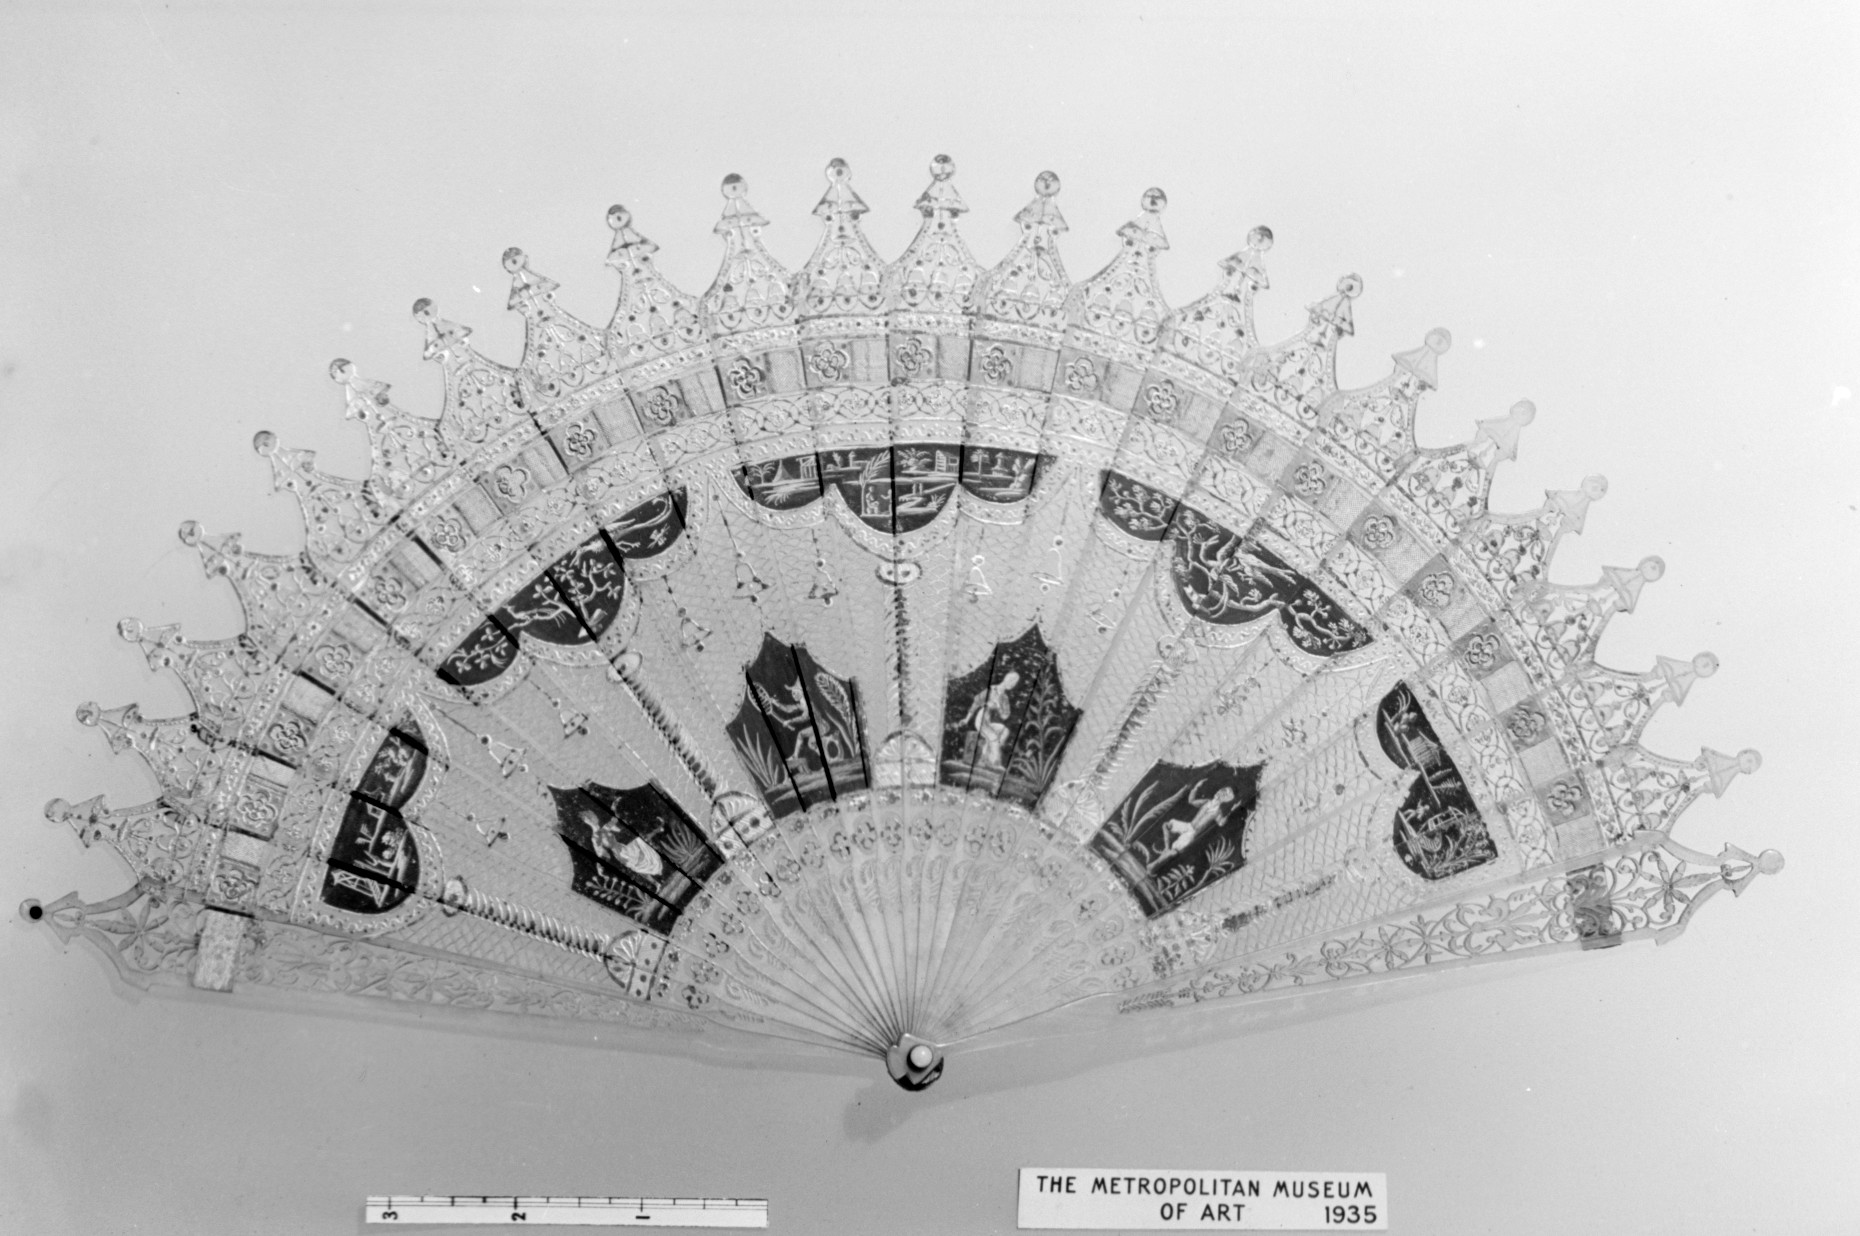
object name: fan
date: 1830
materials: horn